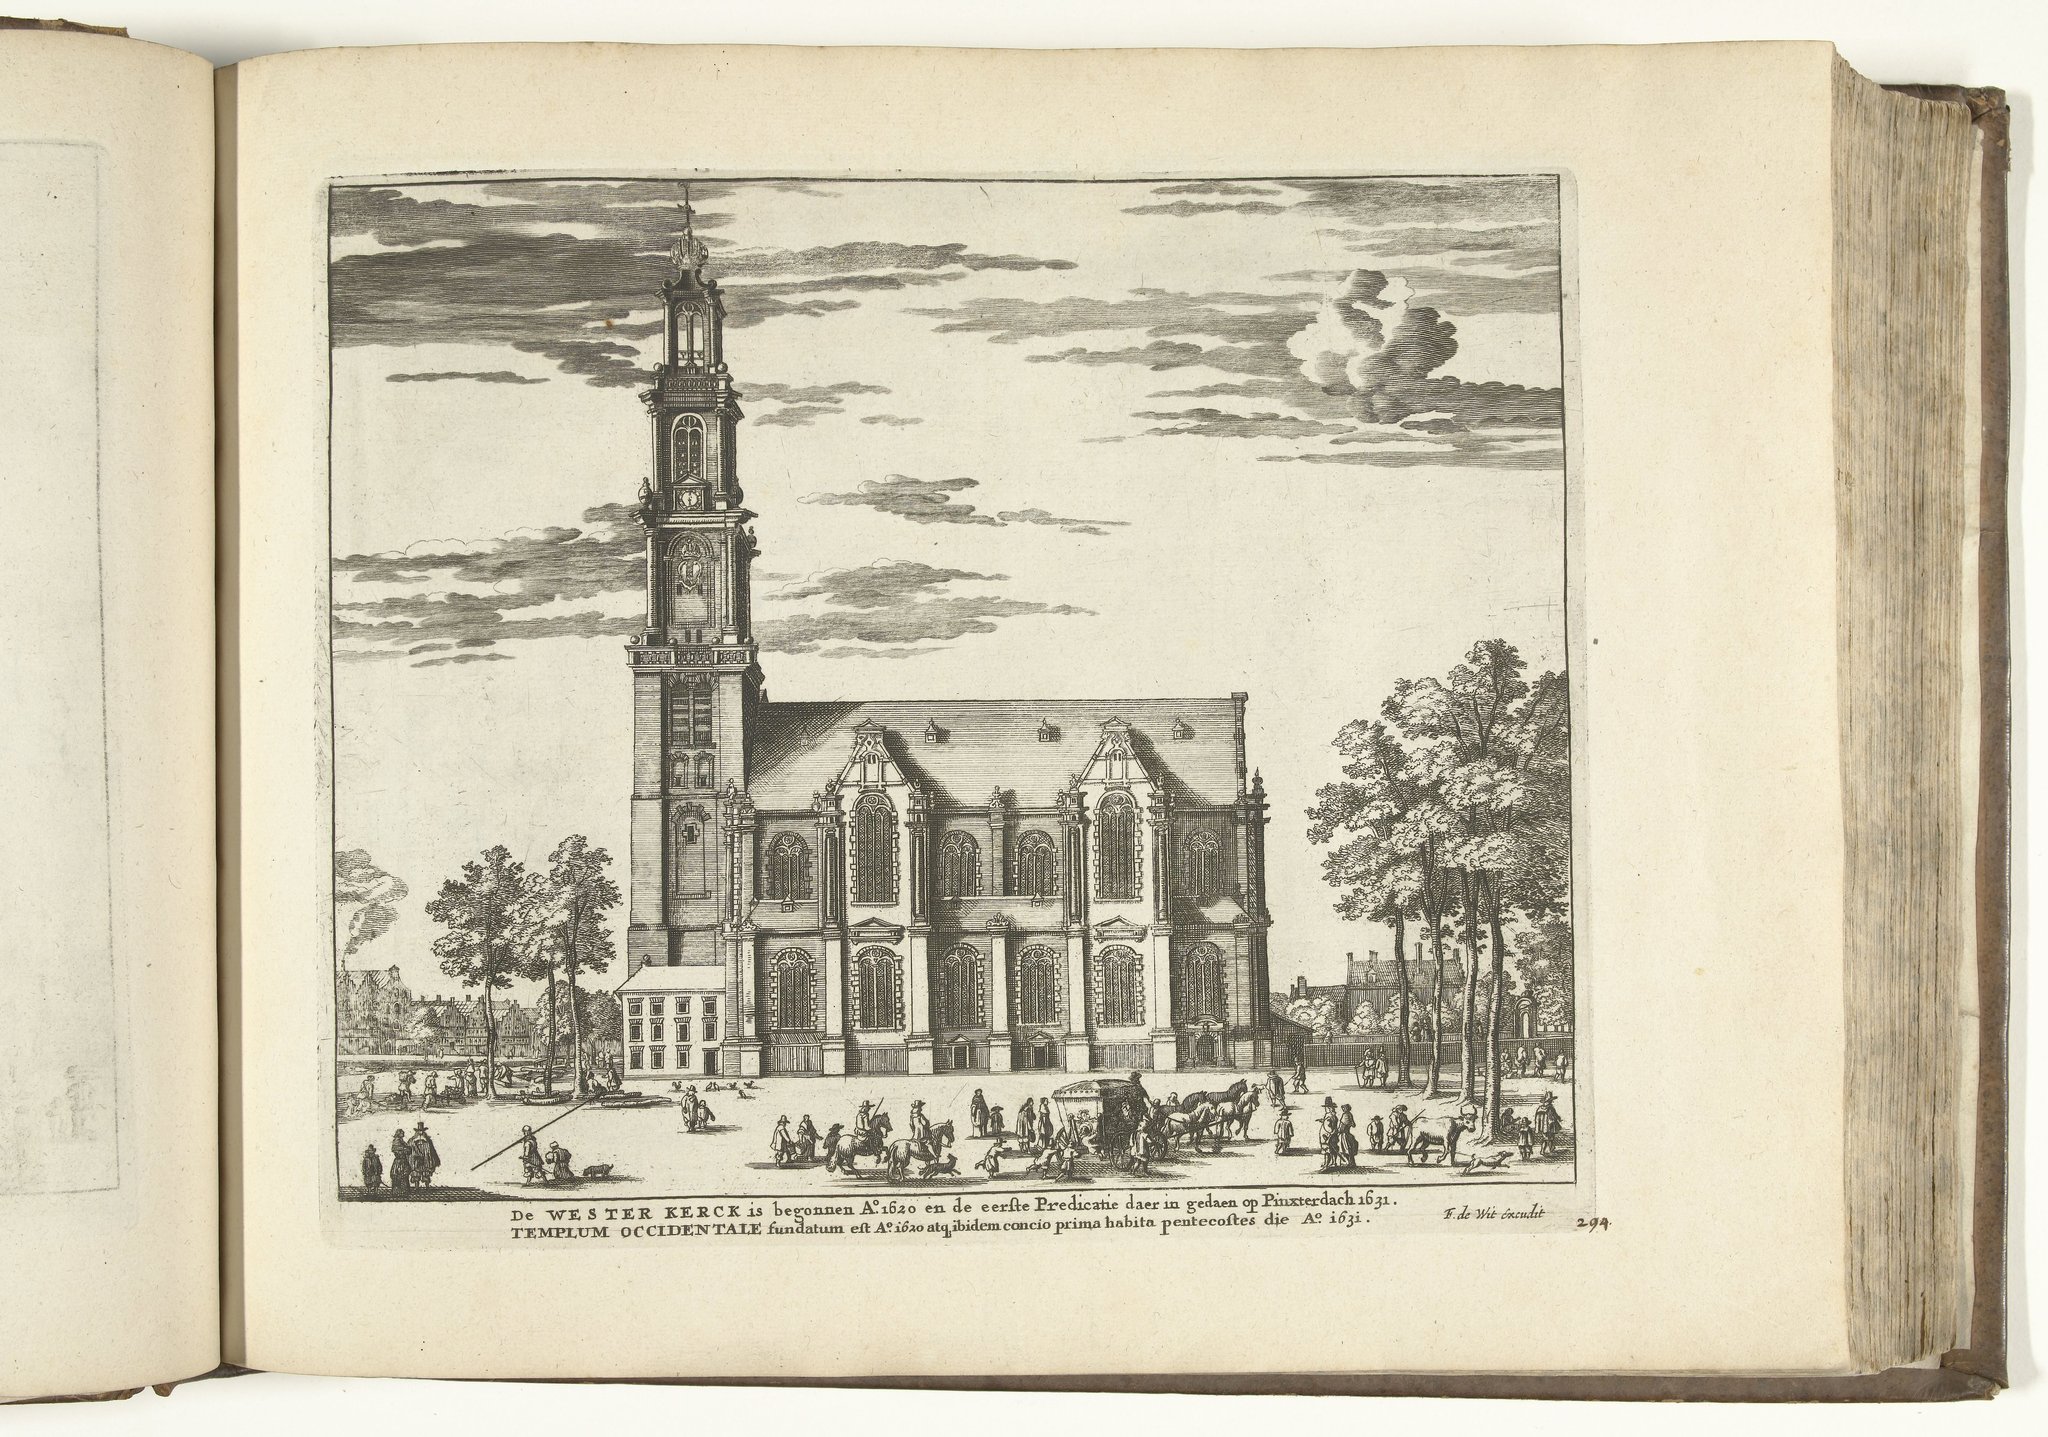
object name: print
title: Gezicht op de Westerkerk te Amsterdam, 1726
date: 1726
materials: paper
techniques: engraving, etching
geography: leiden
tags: westerkerk, spaanse successieoorlog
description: Gezicht op de Westerkerk te Amsterdam. Plaat nr. 294 in deel XIII van het prentwerk: Les Forces de l'Europe, Asie, Afrique et Amerique ... Comme aussi les Cartes des Côtes de France et d'Espagne uit 1726, dit tweede deel met 271 met de hand genummerde platen van vermaarde sterke steden en vestingen in het kader van de Spaanse Successieoorlog 1701-1713. Voor het merendeel zijn deze platen gekopieerd naar de anonieme Franse platen van vermaarde sterke steden en vestingen: in Les forces de l'Europe en in: Le theatre de la guerre, dans les Pays-Bas, beide oorspronkelijk uitgegeven door Nicolas de Fer te Parijs (1693-1697) in het kader van de Negenjarige Oorlog. Titel in het Nederlands en Latijn.